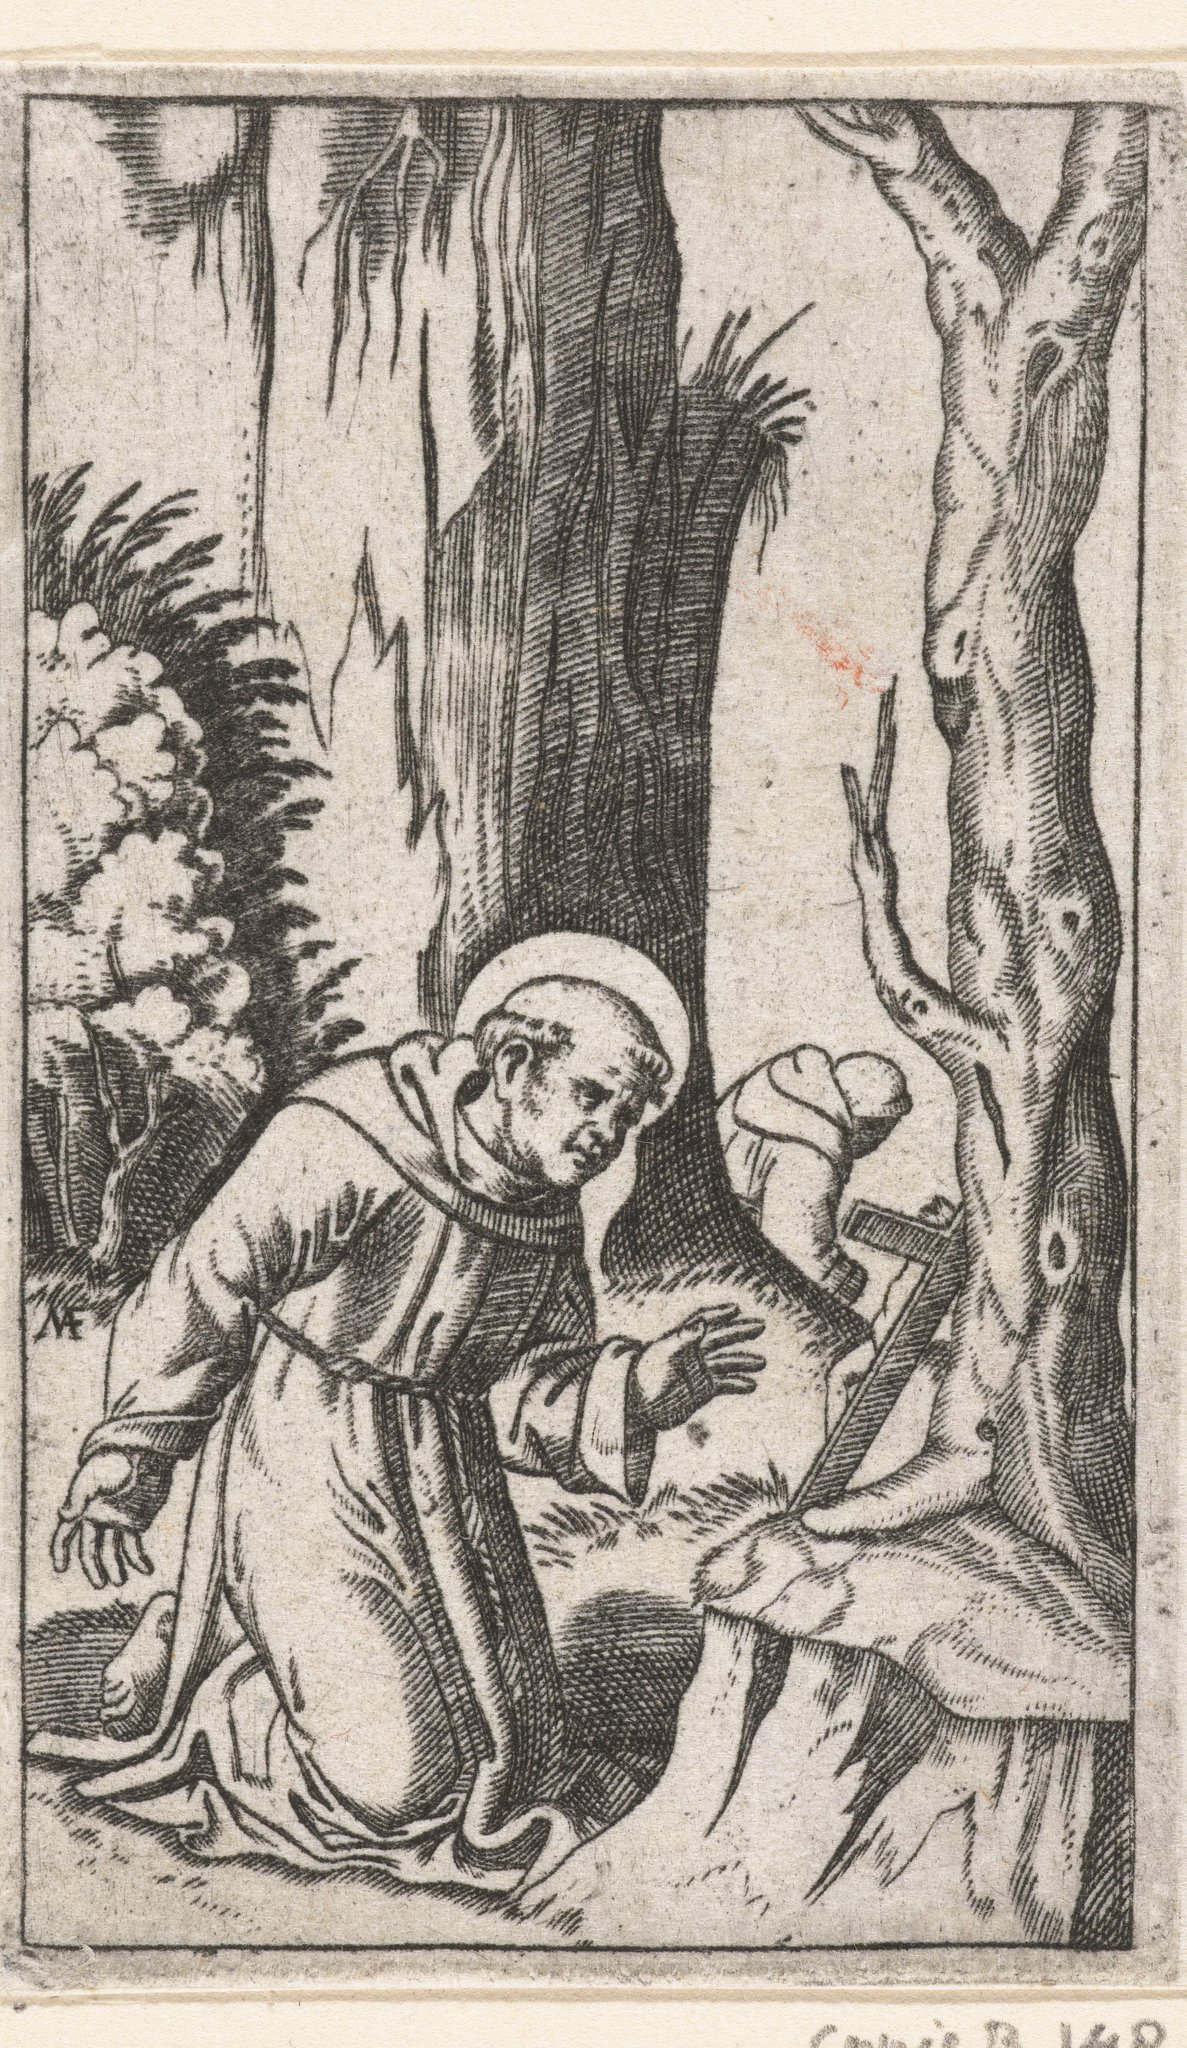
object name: print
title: Heilige Franciscus van Assisi knielend voor crucifix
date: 1500-1575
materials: paper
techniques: engraving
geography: italy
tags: founder of the order of friars minor (franciscans), francis(cus) of assisi; possible attributes: book, crucifix, lily, skull, stigmata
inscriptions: collector's mark: Lugt 12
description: Kopie naar prent van Marcantonio Raimondi.